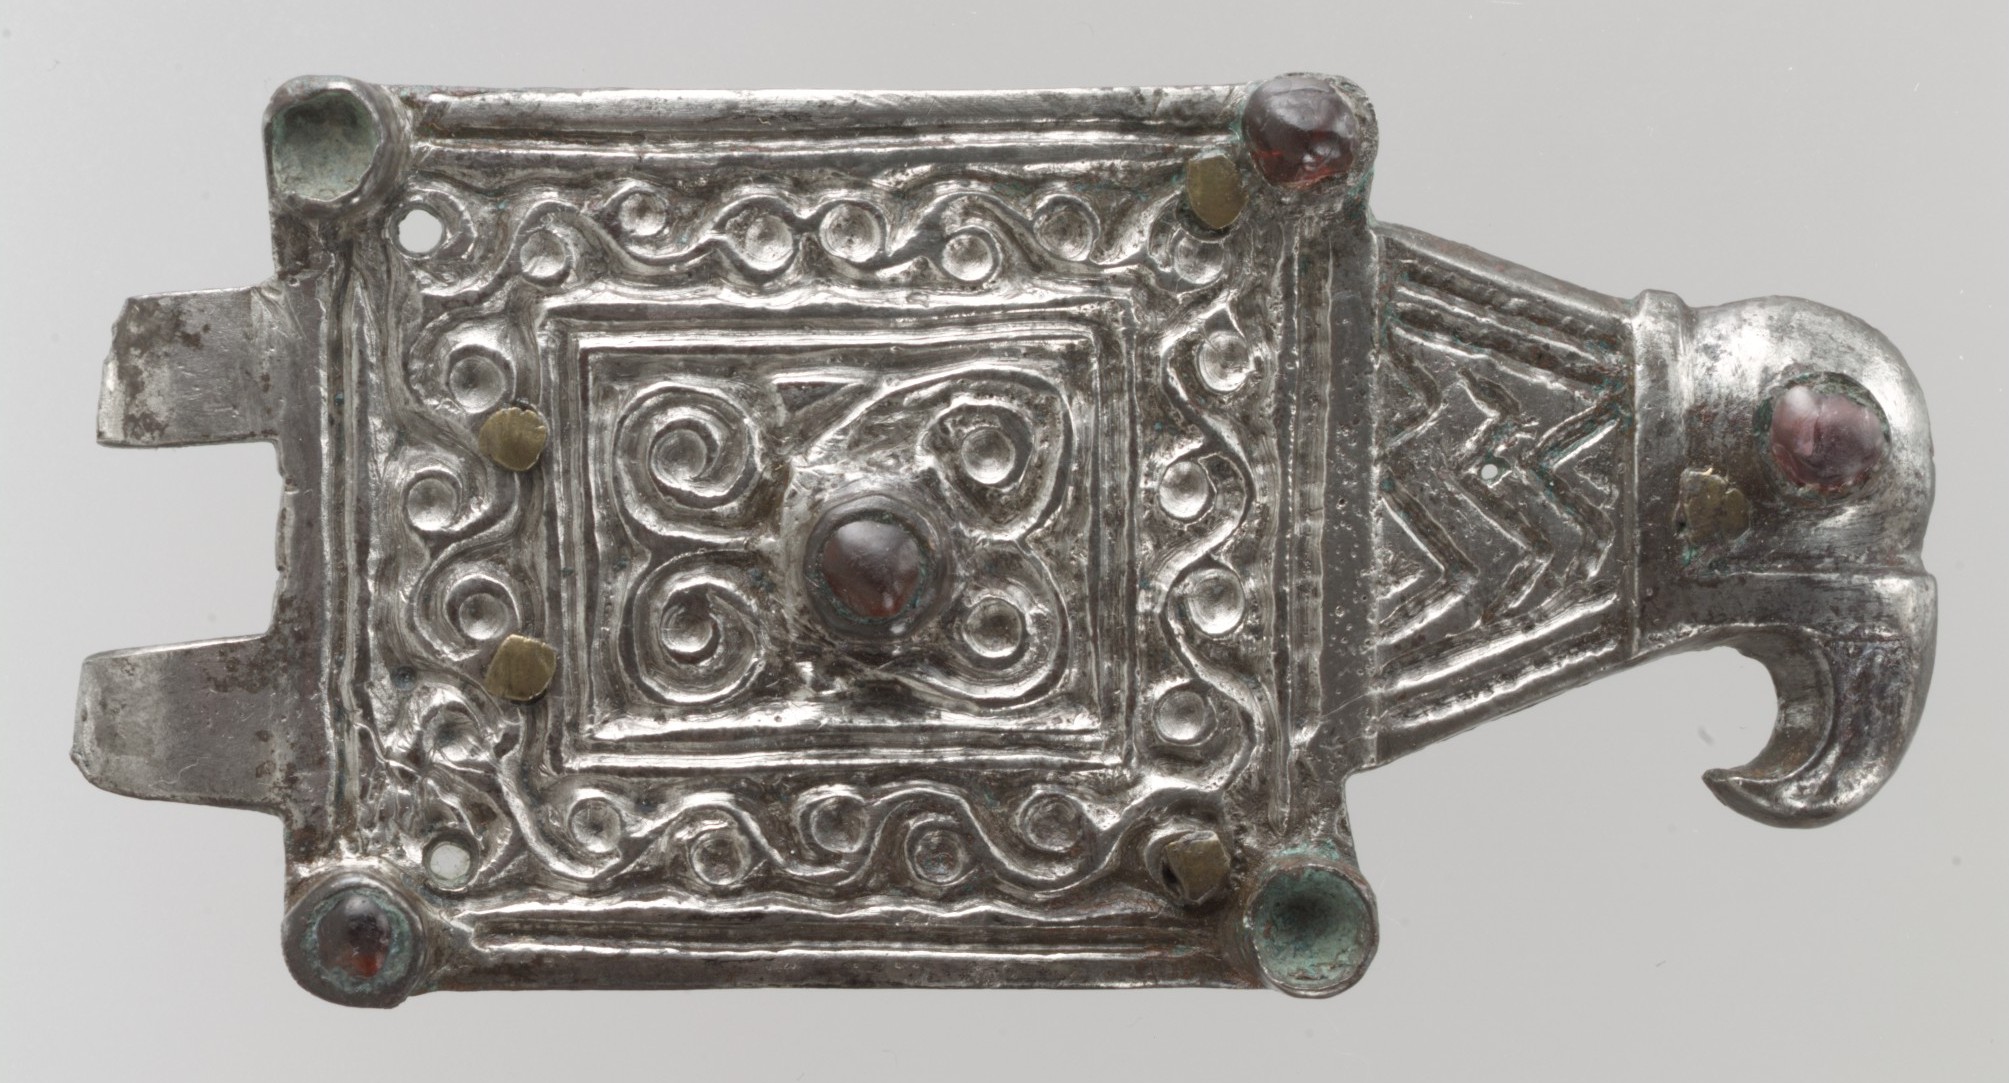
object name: buckle plate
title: Belt Buckle with an Eagle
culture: ostrogothic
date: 500-700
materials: garnet, silver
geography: ukraine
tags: eagles